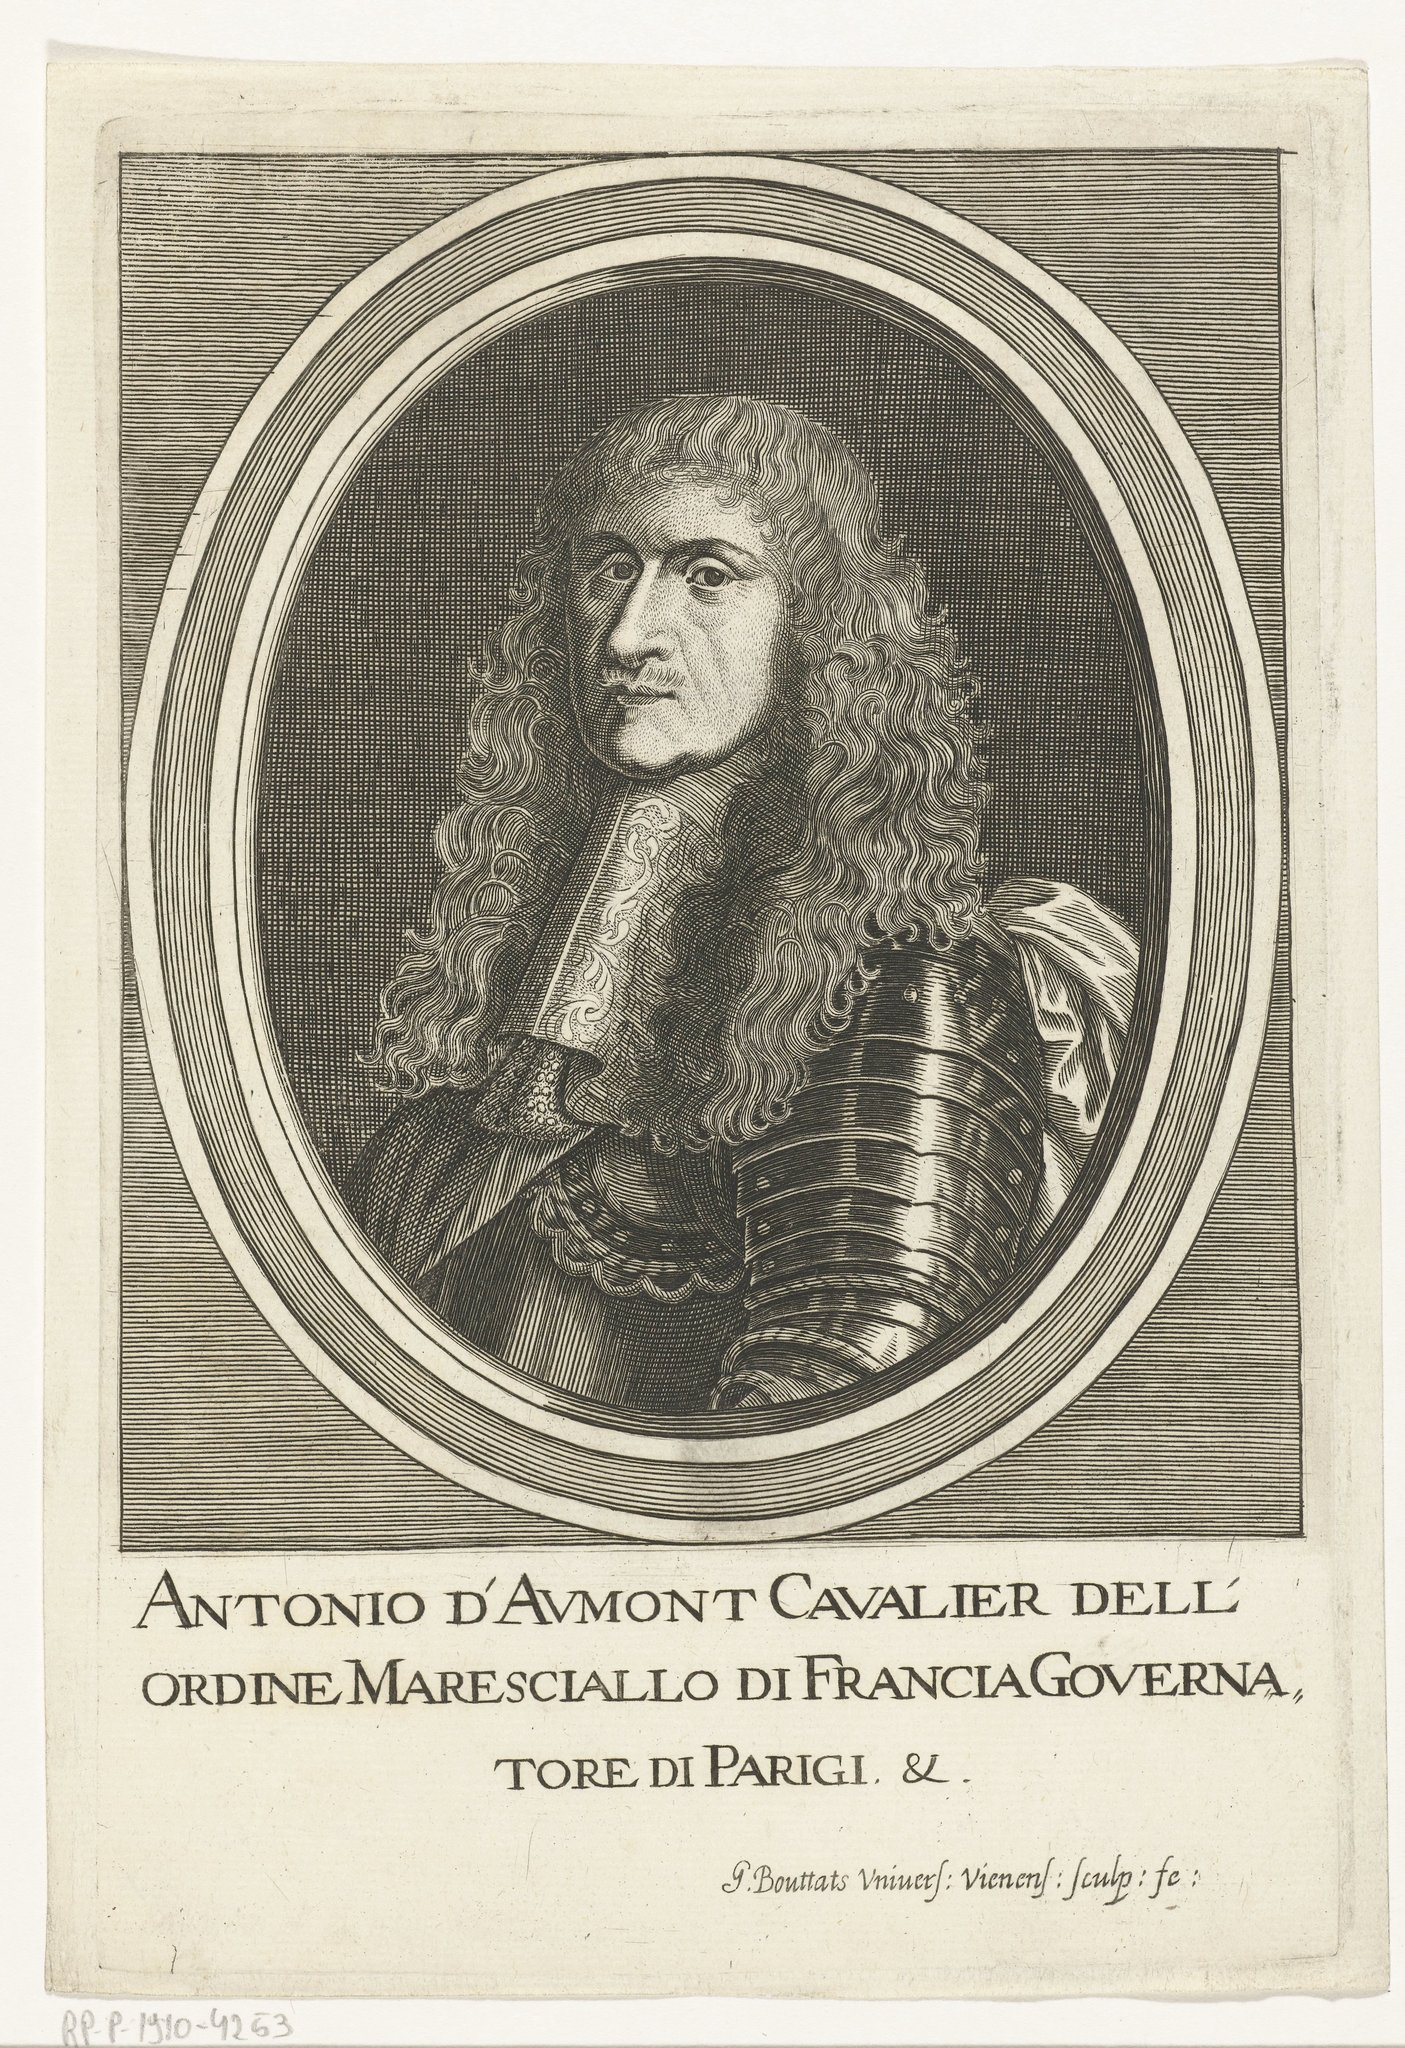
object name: print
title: Antonio d'Aumont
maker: gerard bouttats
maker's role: print maker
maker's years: 1630-1668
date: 1655-1668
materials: paper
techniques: engraving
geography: vienna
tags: gouverneur, antoine d' aumont de rochbaron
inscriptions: collector's mark: Lugt 2228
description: Portret in een ovale lijst van Antonio D'Aumont, maarschalk van Frankrijk en gouverneur van Parijs. Buste naar links.. D'Aumont draagt een harnas. De prent heeft een Italiaans onderschrift met de naam van de geportretteerde.